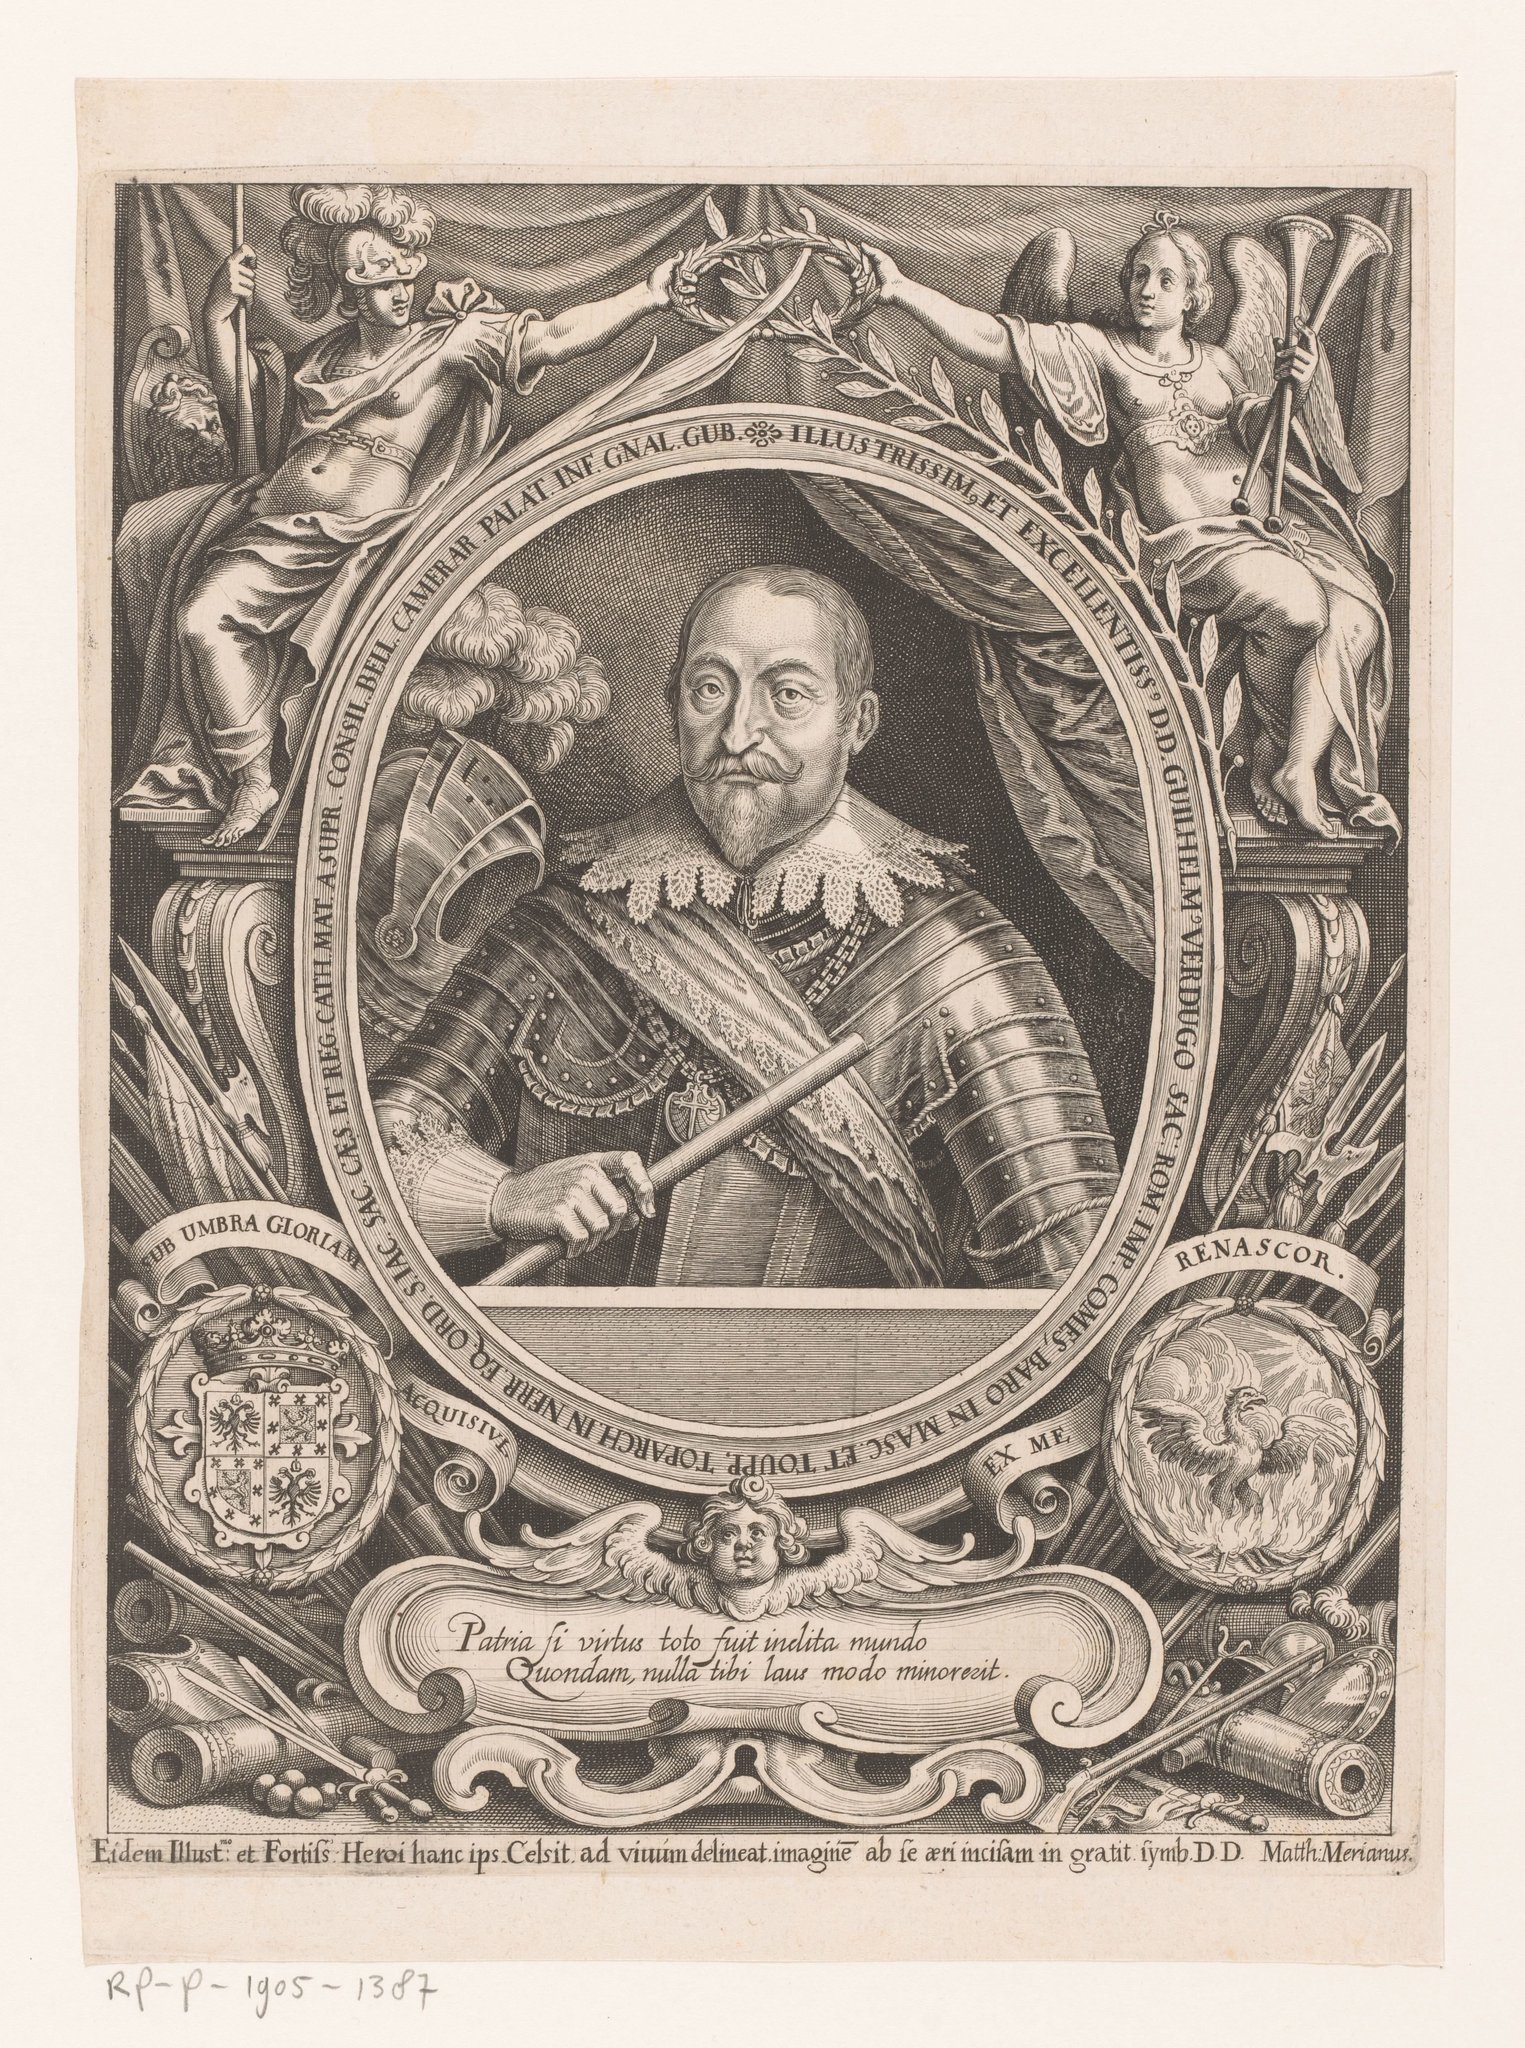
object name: print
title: Portret van Wilhelm graaf Verdugo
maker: matthäus merian (i)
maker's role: print maker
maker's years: 1593-1650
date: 1603-1650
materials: paper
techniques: engraving, etching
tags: helmet, cherubs, i.e. children's heads with wings, (story of) minerva (pallas, athena), armour, weapons, 'victoria'; 'vittoria', 'vittoria navale', 'vittoria degl'antichi' (ripa), crowning with laurel, baton of general, fabulous animals ~ birds: phoenix, armorial bearing, heraldry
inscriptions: collector's mark: Lugt 2228